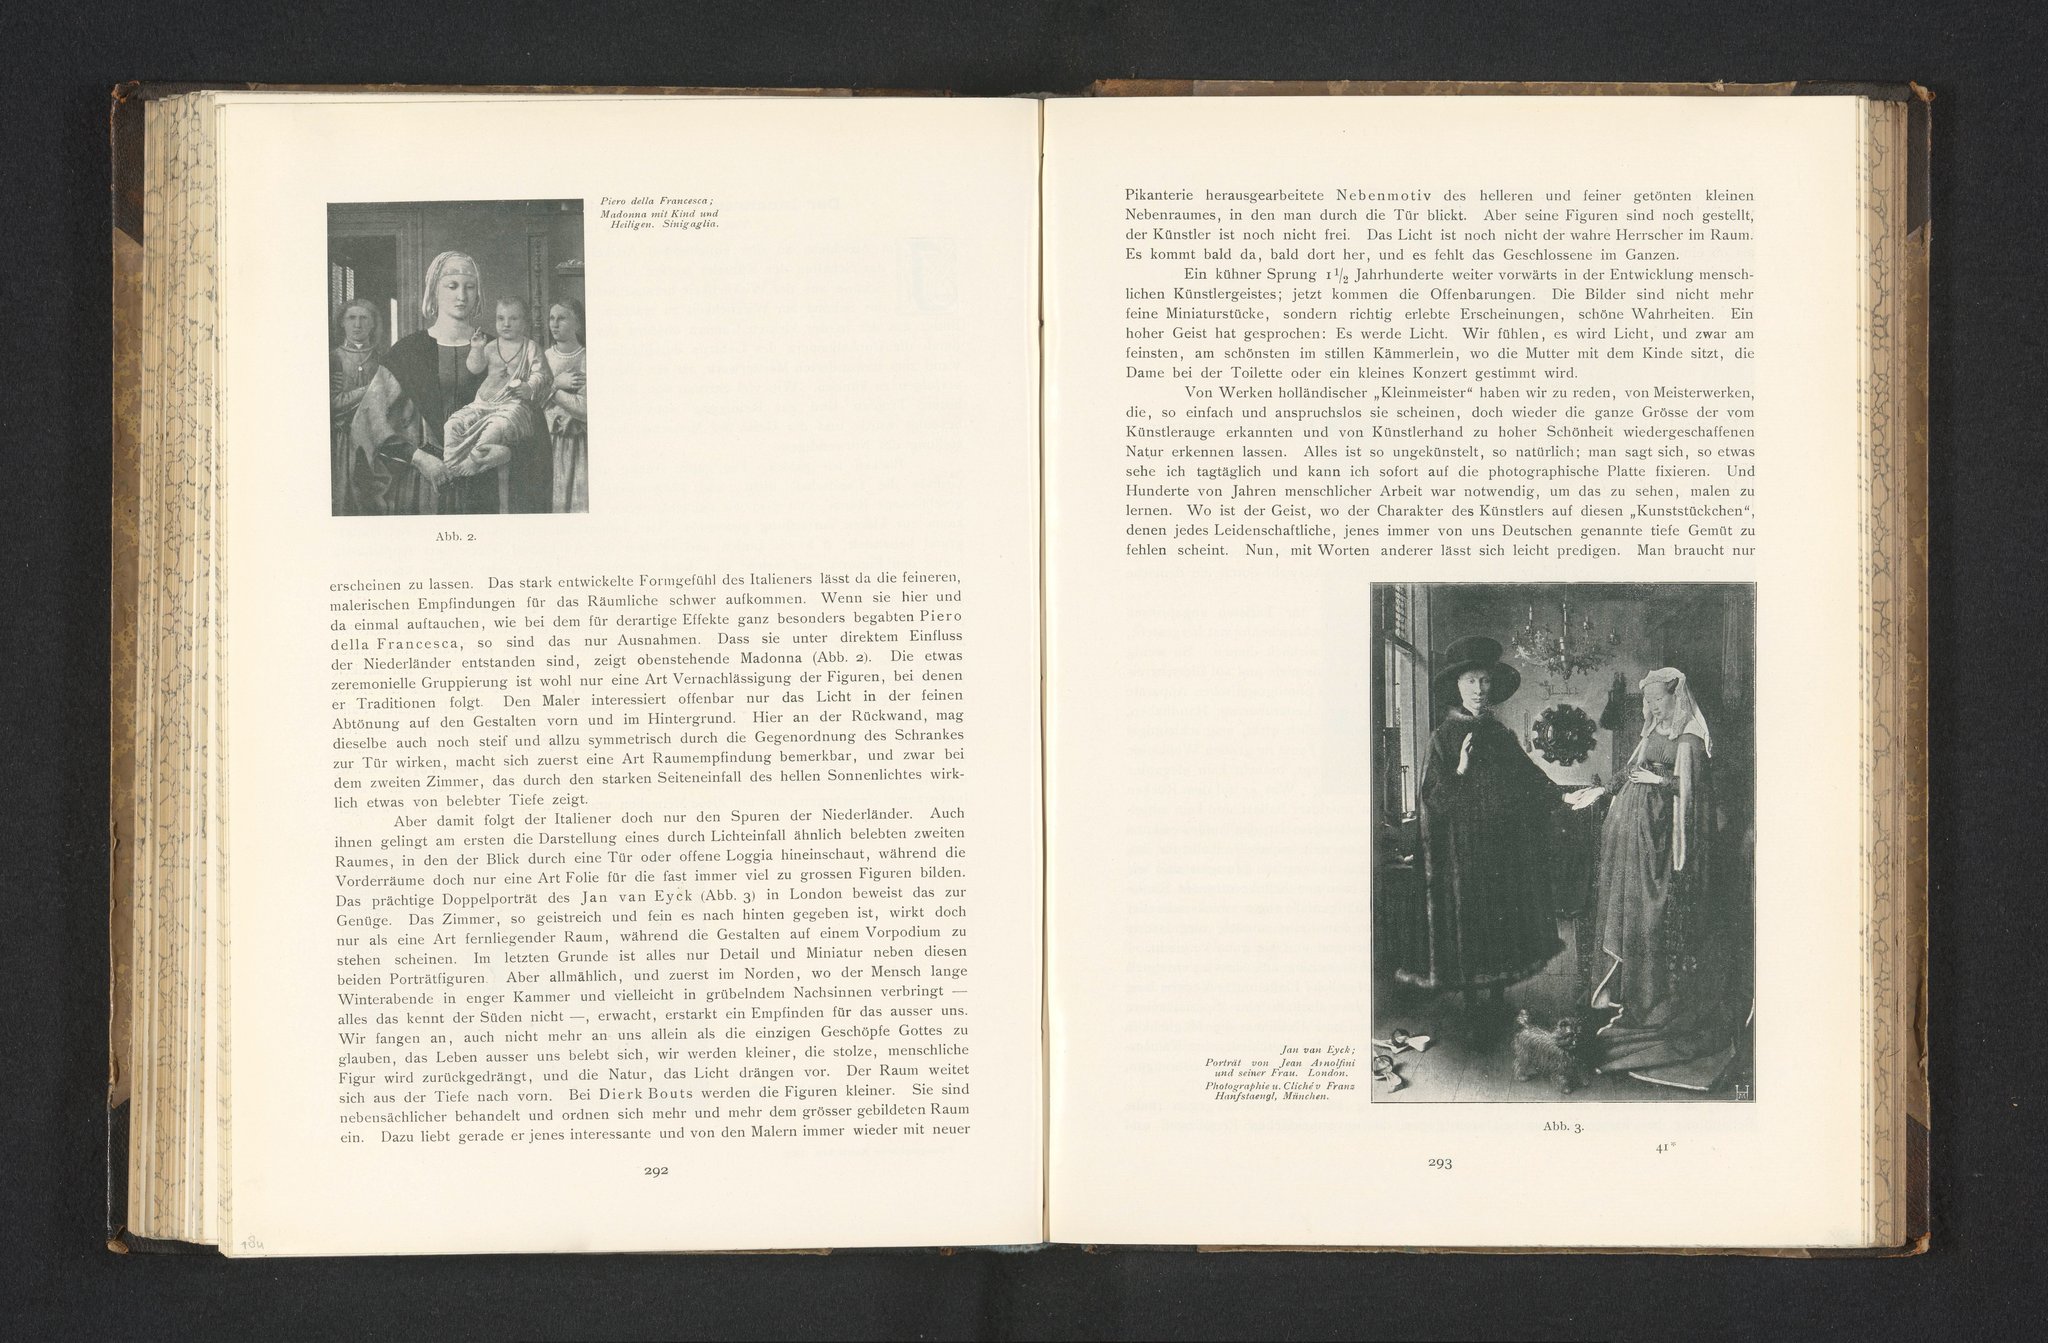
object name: page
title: Reproductie van Madonna met kind en heiligen door Piero della Francesca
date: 1898-1903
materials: paper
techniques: autotype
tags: mary standing (or half-length), the christ-child in front of her, close to her bosom; sitting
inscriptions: number: ‘Abb. 2’